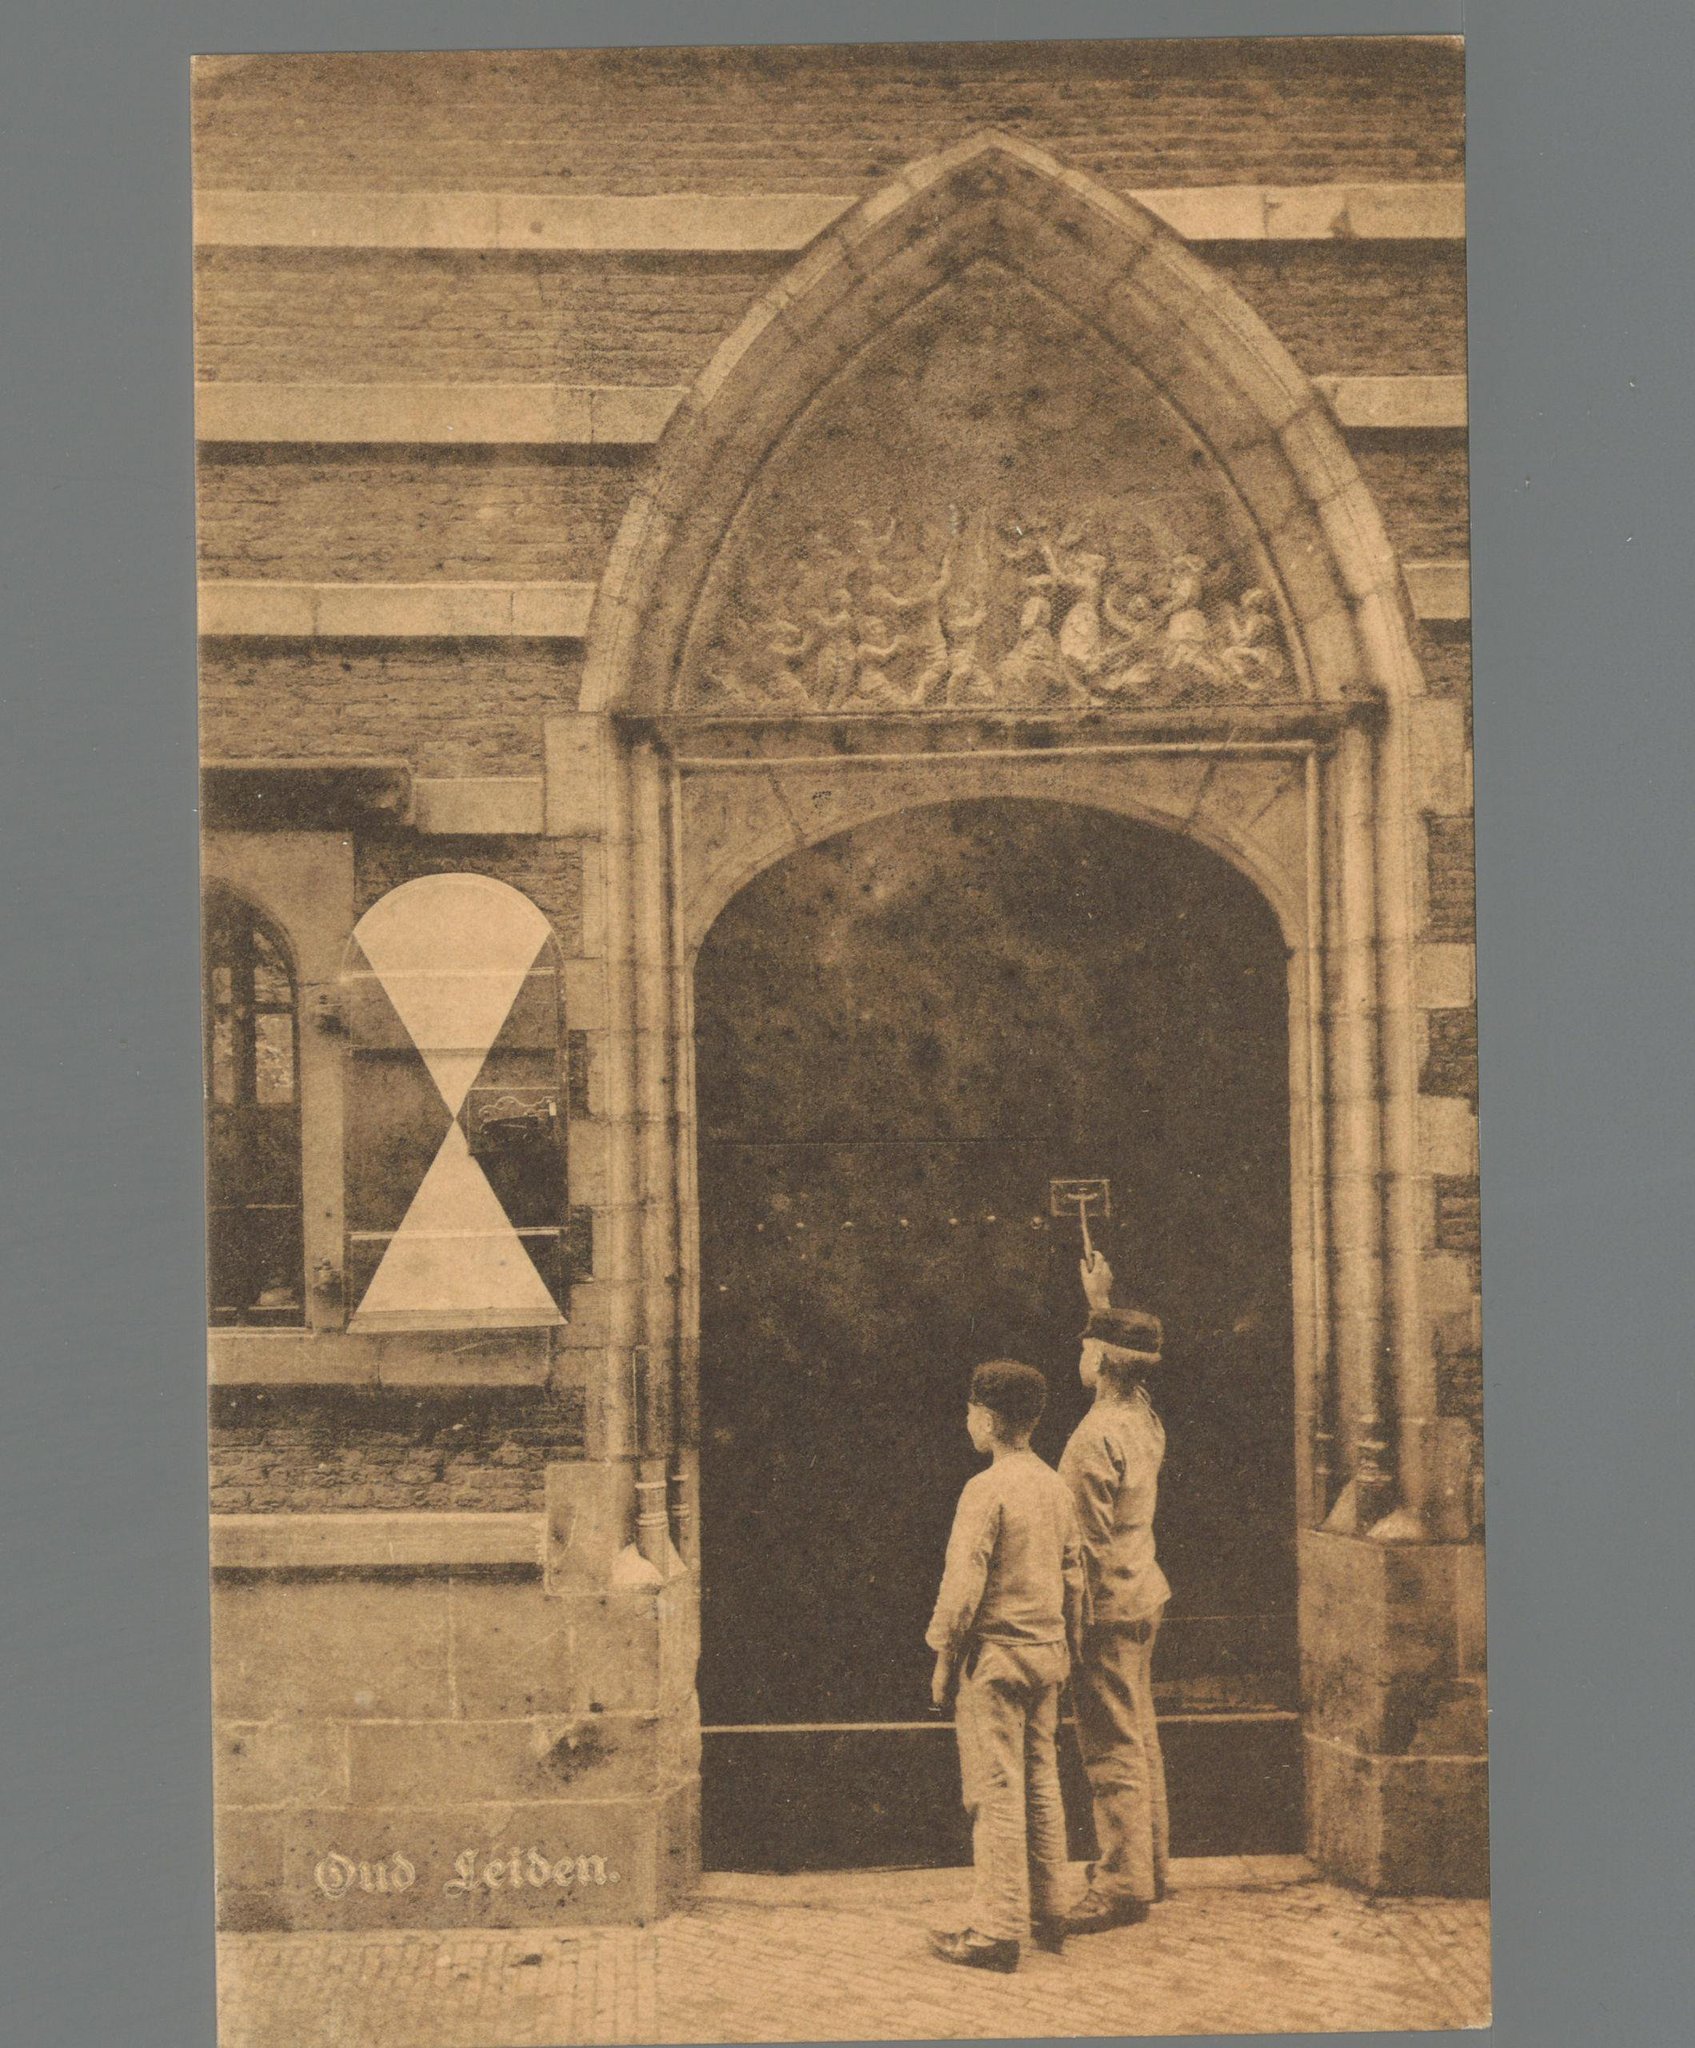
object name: photomechanical print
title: Oud Leiden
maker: Anonymous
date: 1905-1930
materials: cardboard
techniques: photograph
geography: leiden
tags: gate, entrance, orphanage